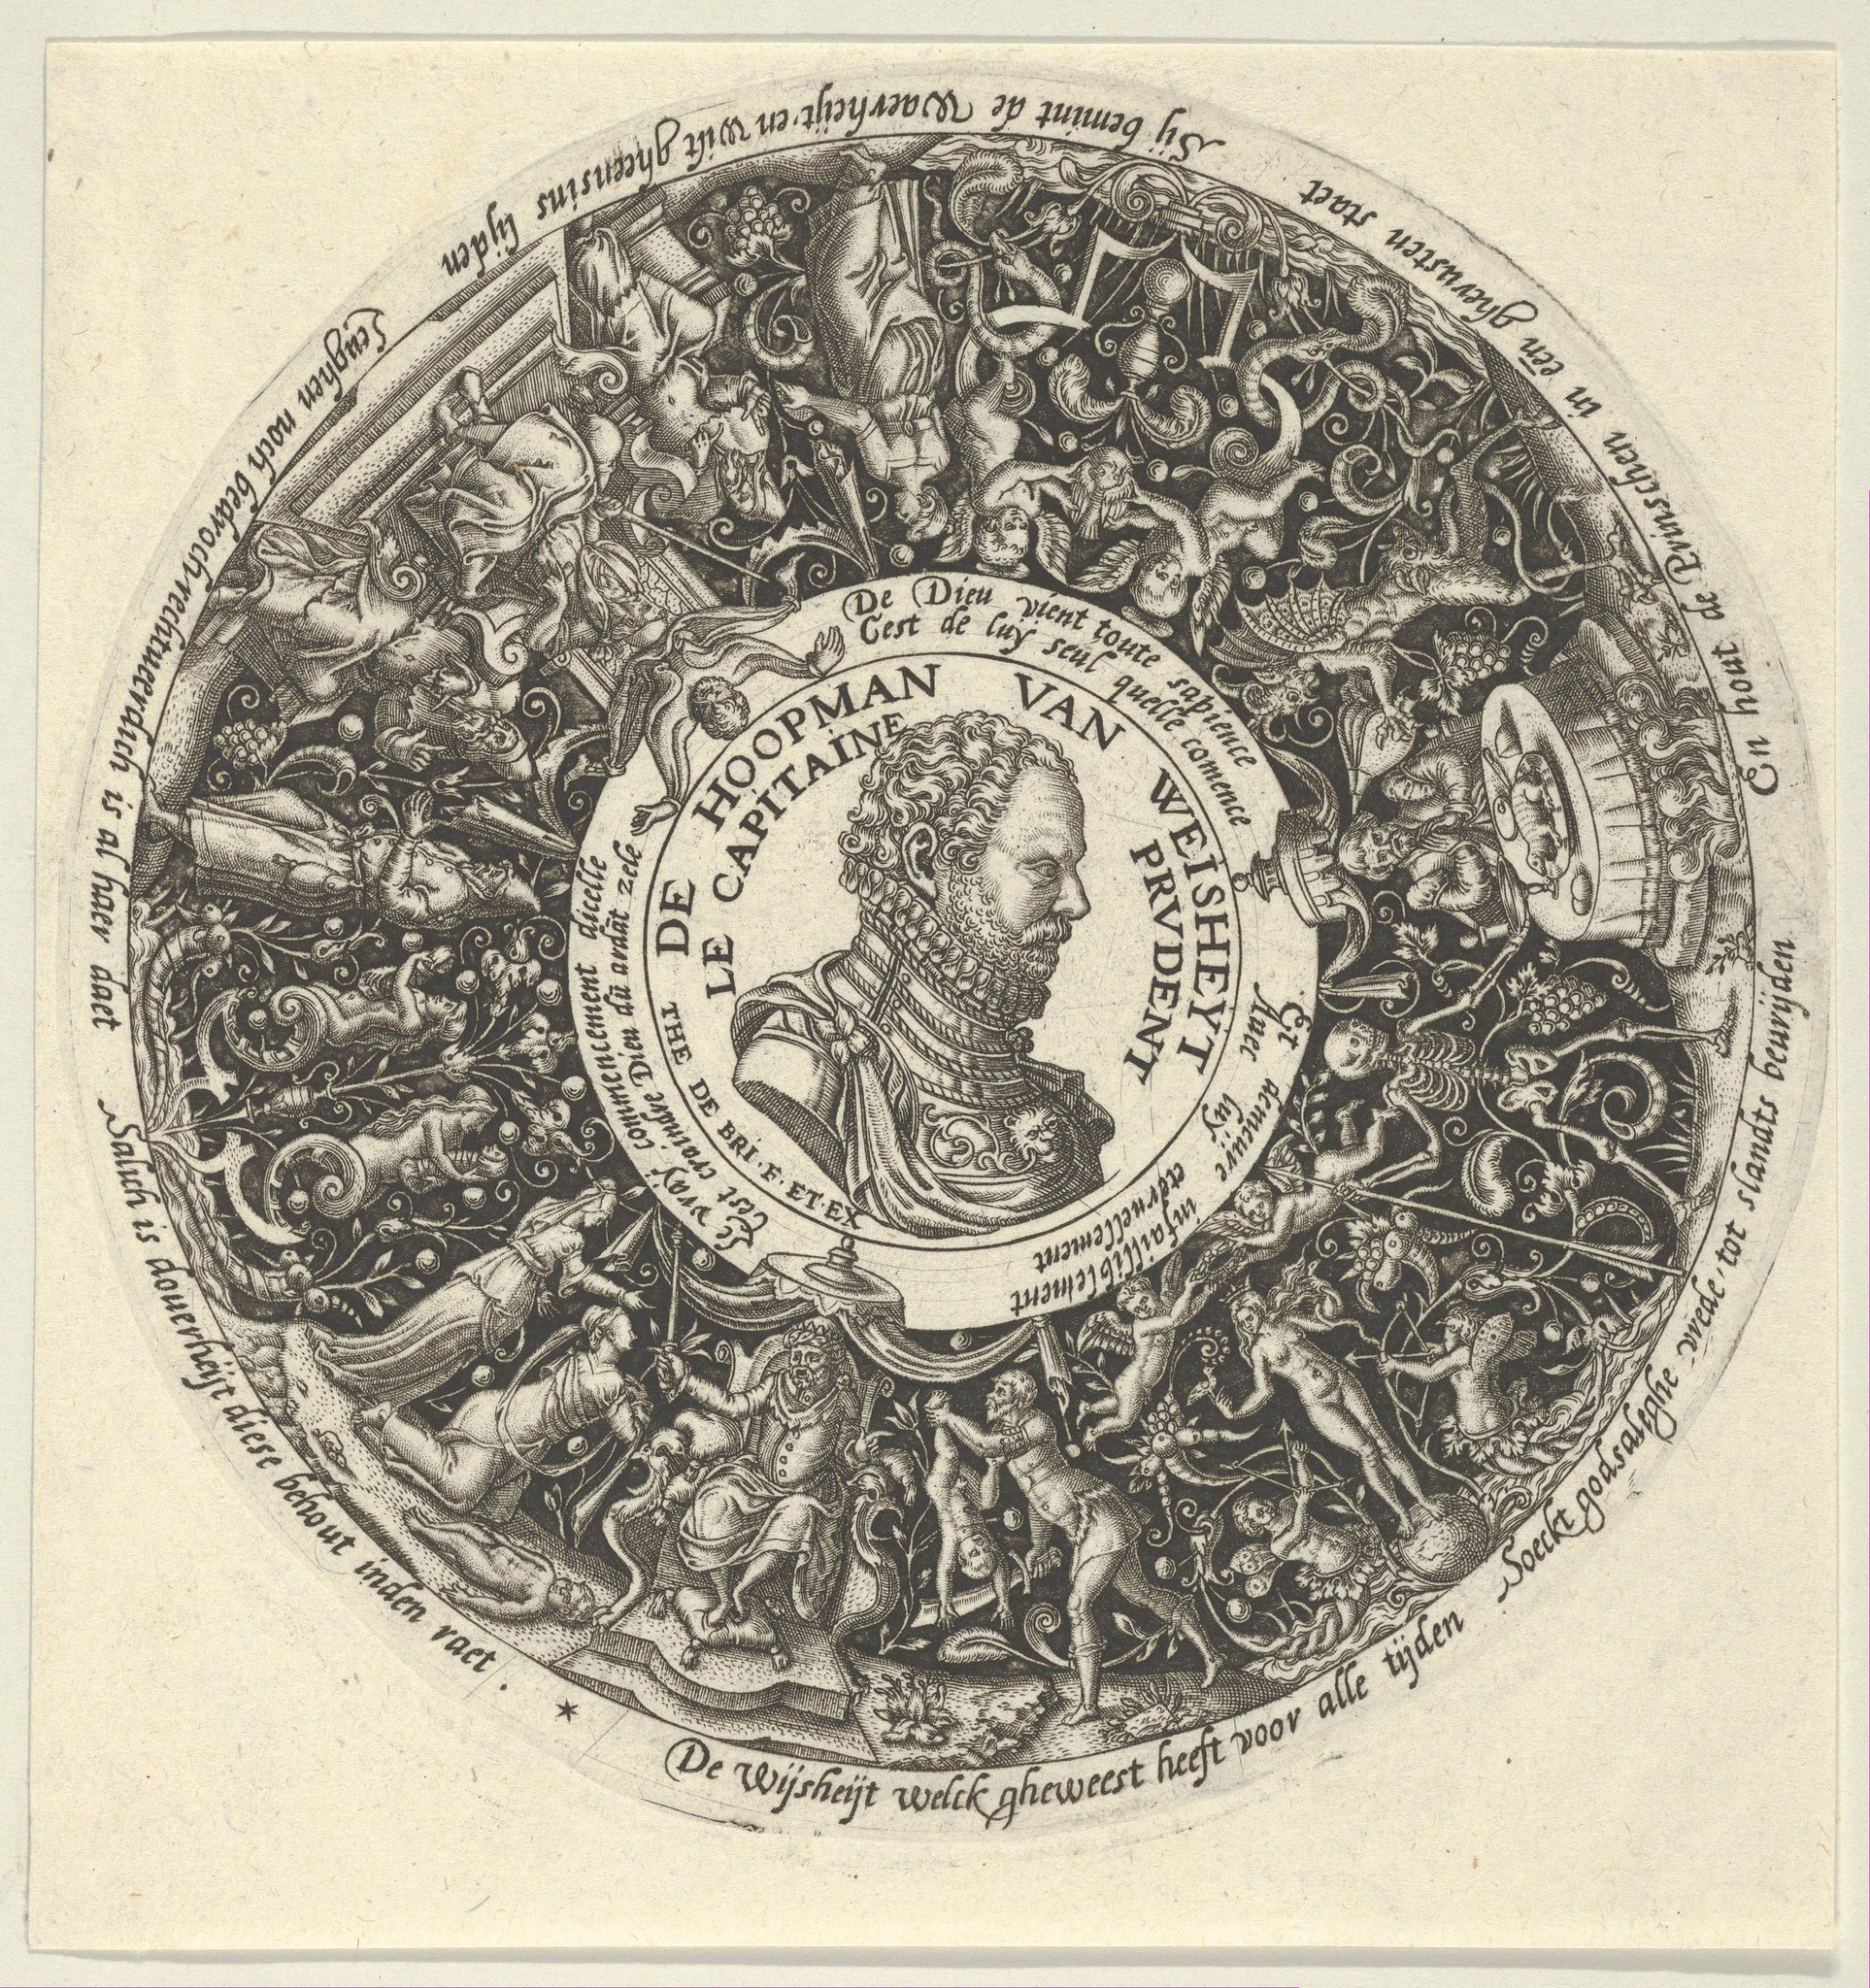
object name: print ornament architecture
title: Portrait of William I of Orange, from a Series of Tazza Designs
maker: theodor de bry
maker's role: artist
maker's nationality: netherlandish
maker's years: 1528-1598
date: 1588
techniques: engraving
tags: medallions,kings,profiles